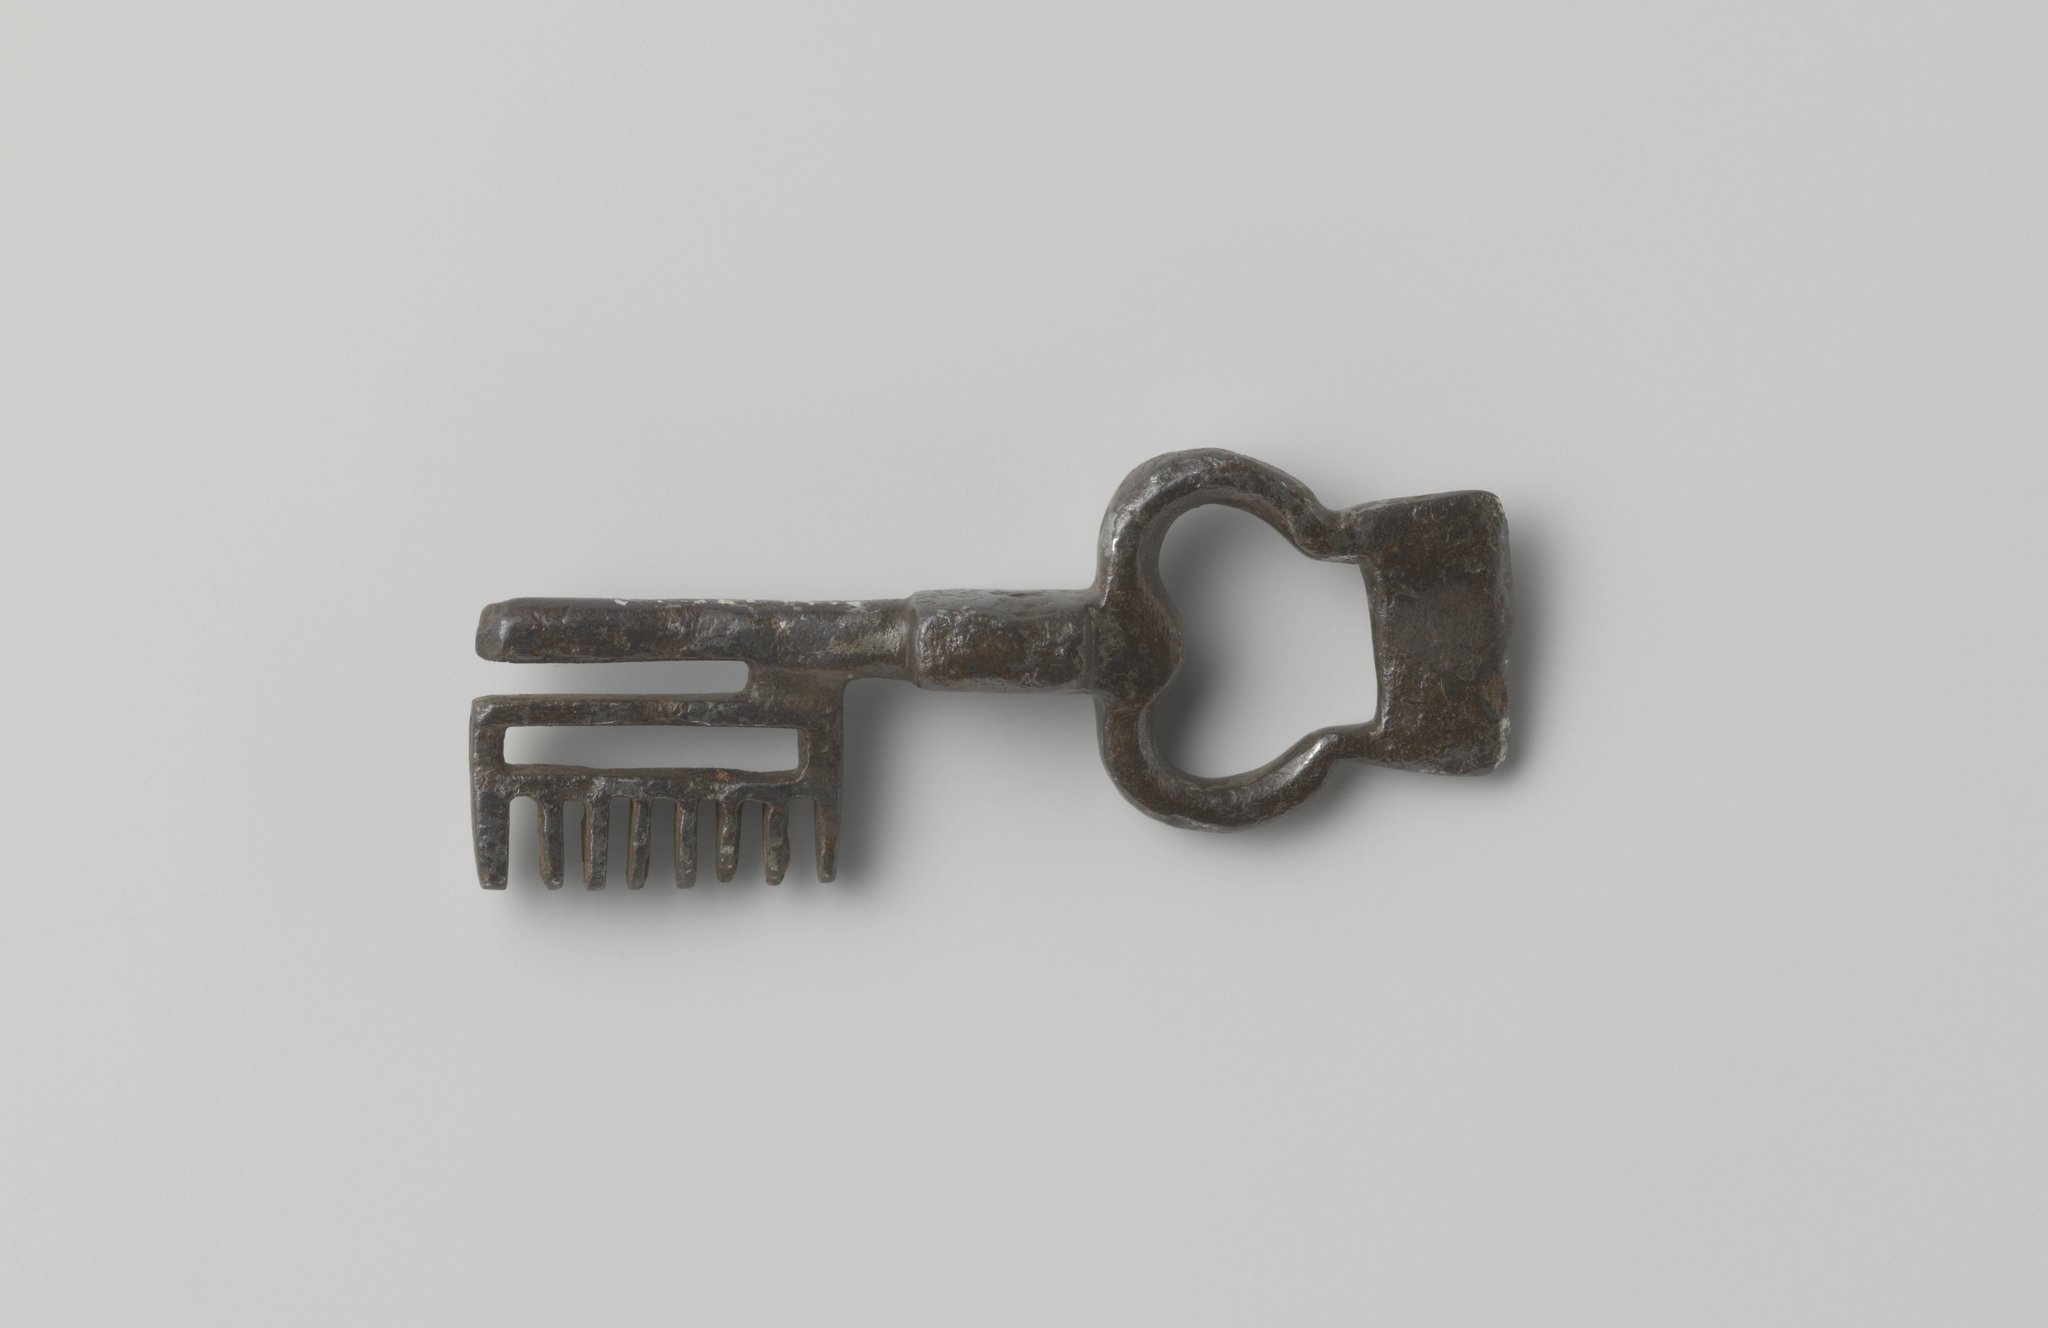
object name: key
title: Dopsleutel van staal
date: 1300-1500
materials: steel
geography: france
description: Stalen dopsleutel met opengetande baard, ring aan de bovenzijde recht.